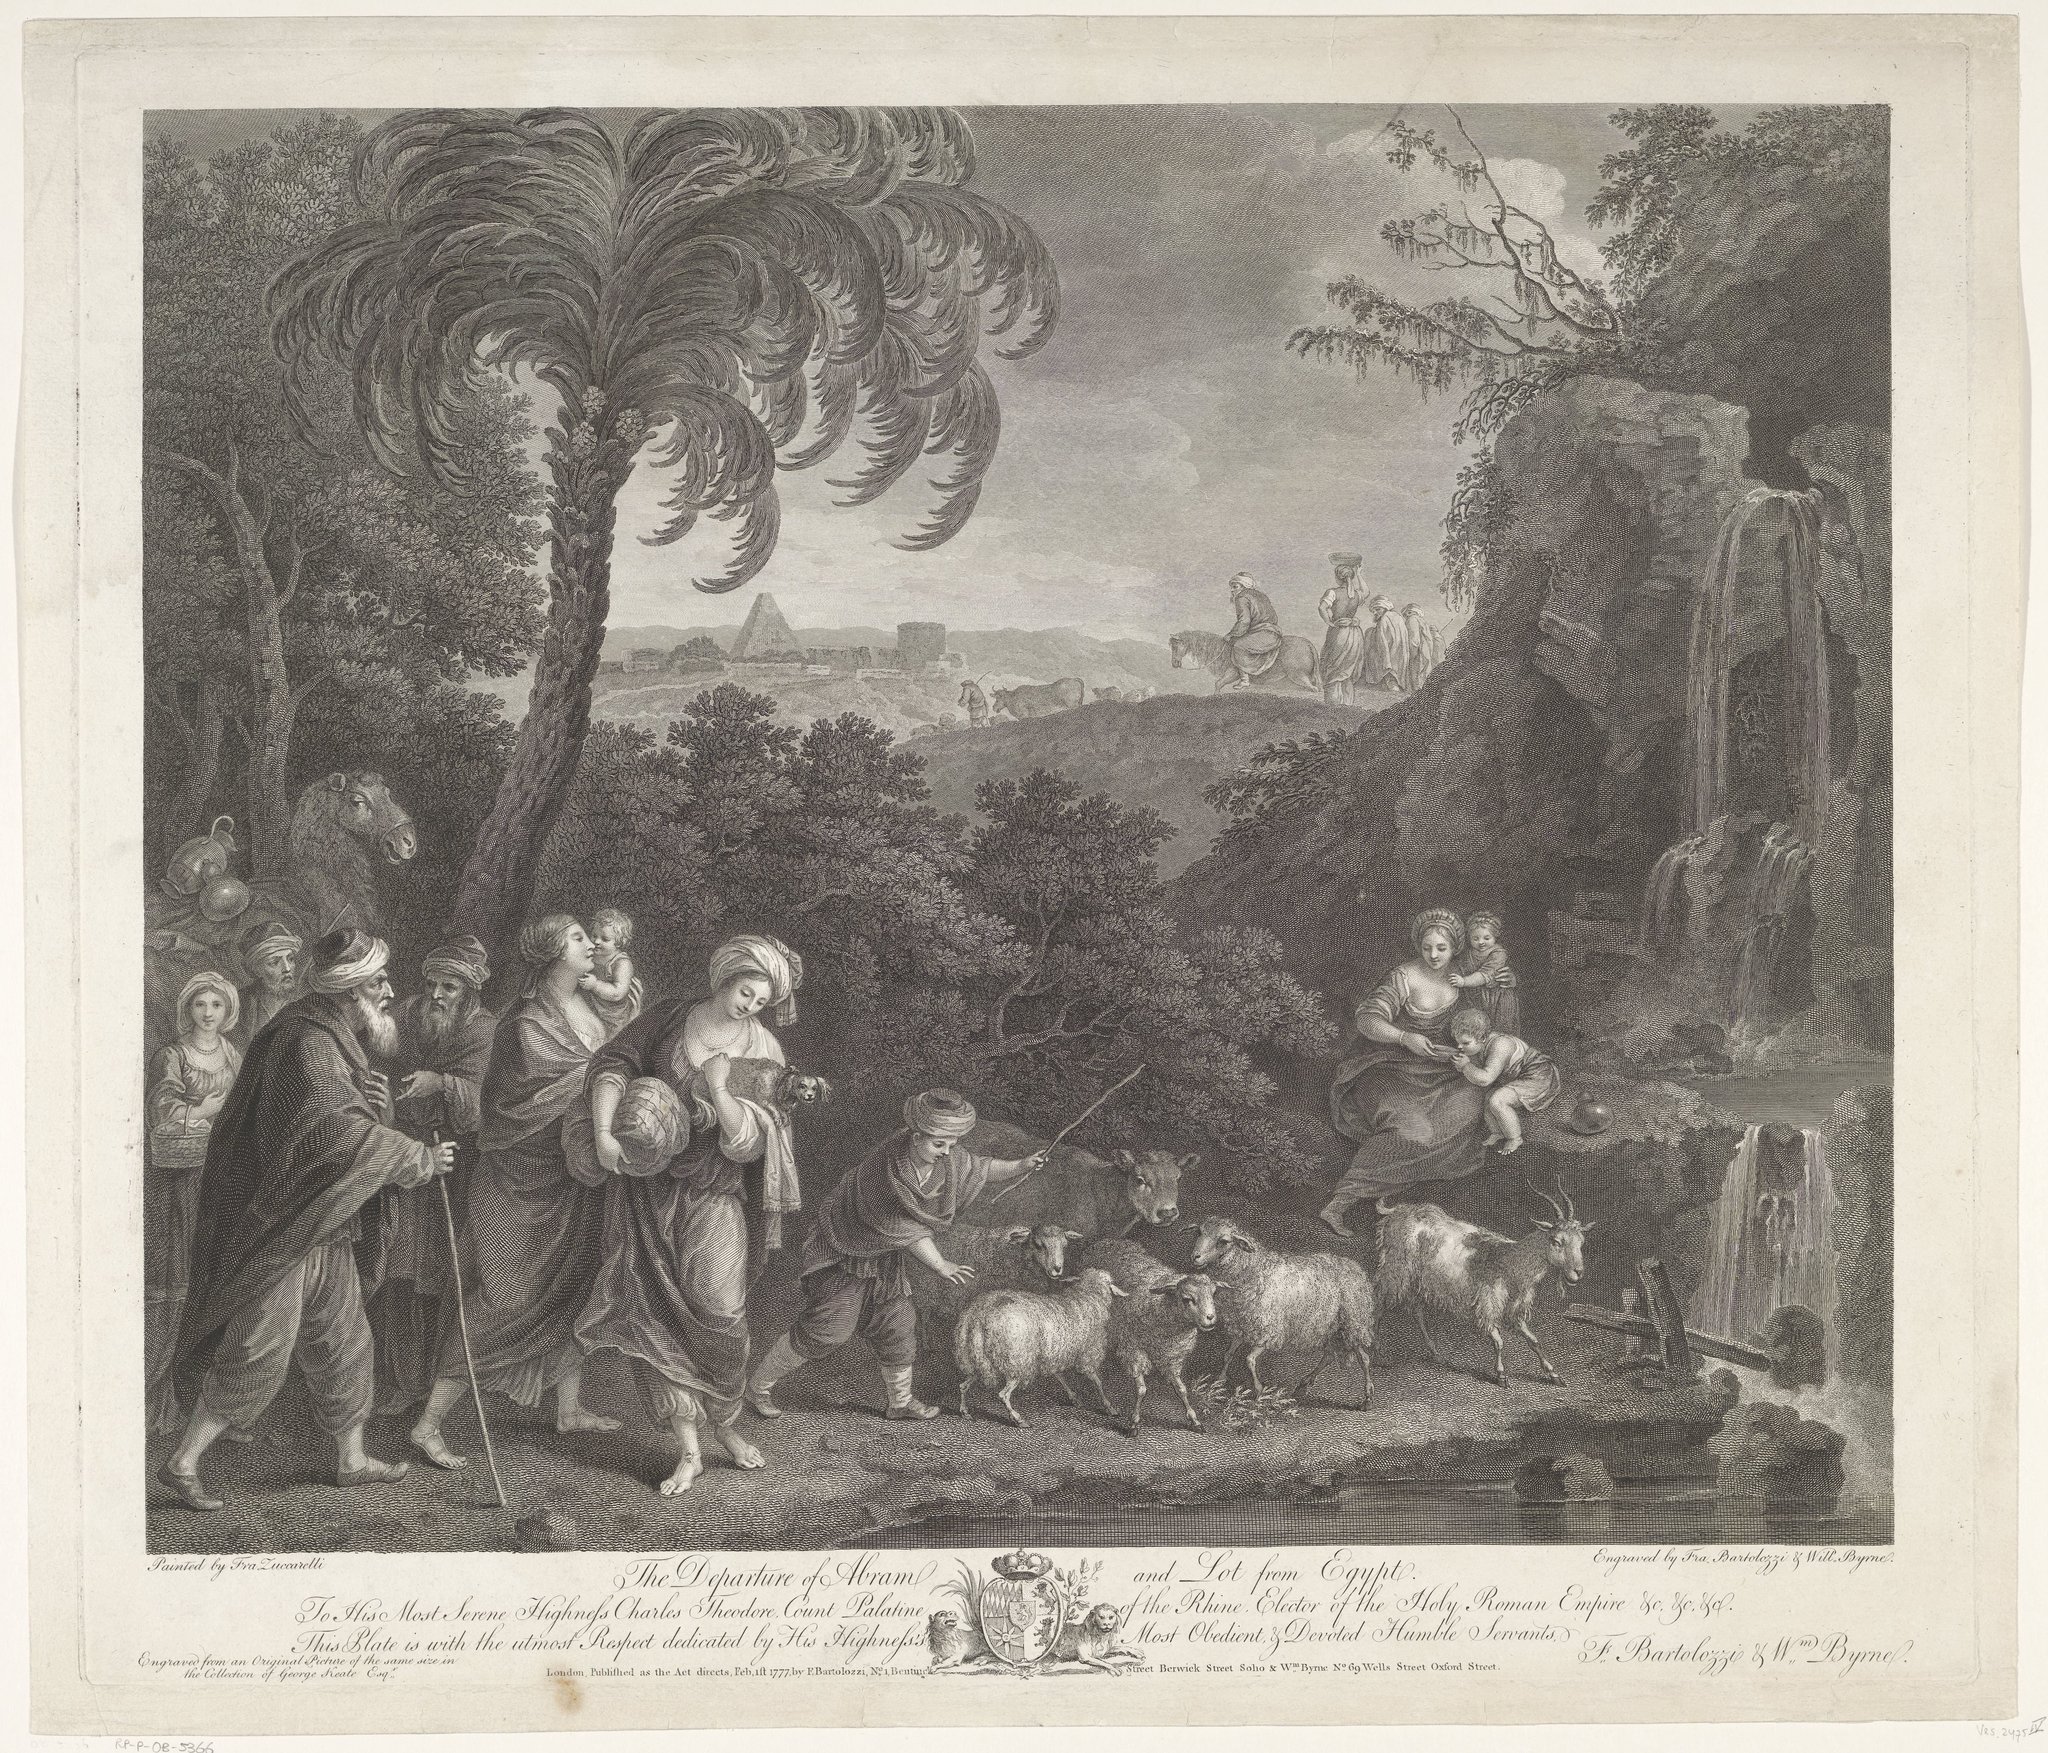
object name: print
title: The departure of Abram and Lot from Egypt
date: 1777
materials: paper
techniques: engraving, etching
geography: london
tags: abraham leaves egypt with sarah, lot, and his possessions, hoofed animals: camel, city-view, and landscape with man-made constructions, (traveller) resting in the open air, 'en route', traveller under way, herd, flock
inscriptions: collector's mark: Lugt 2228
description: Een landschap met een jongen die een kleine kudde vee aanstuurt. Achter de jongen lopen een vrouw met een hondje op de arm, een vrouw met een kind, drie mannen, een vrouw met een mand en een kameel. Rechts zitten een vrouw en twee kinderen die water drinken naast een waterval. Tekst en wapen in ondermarge.